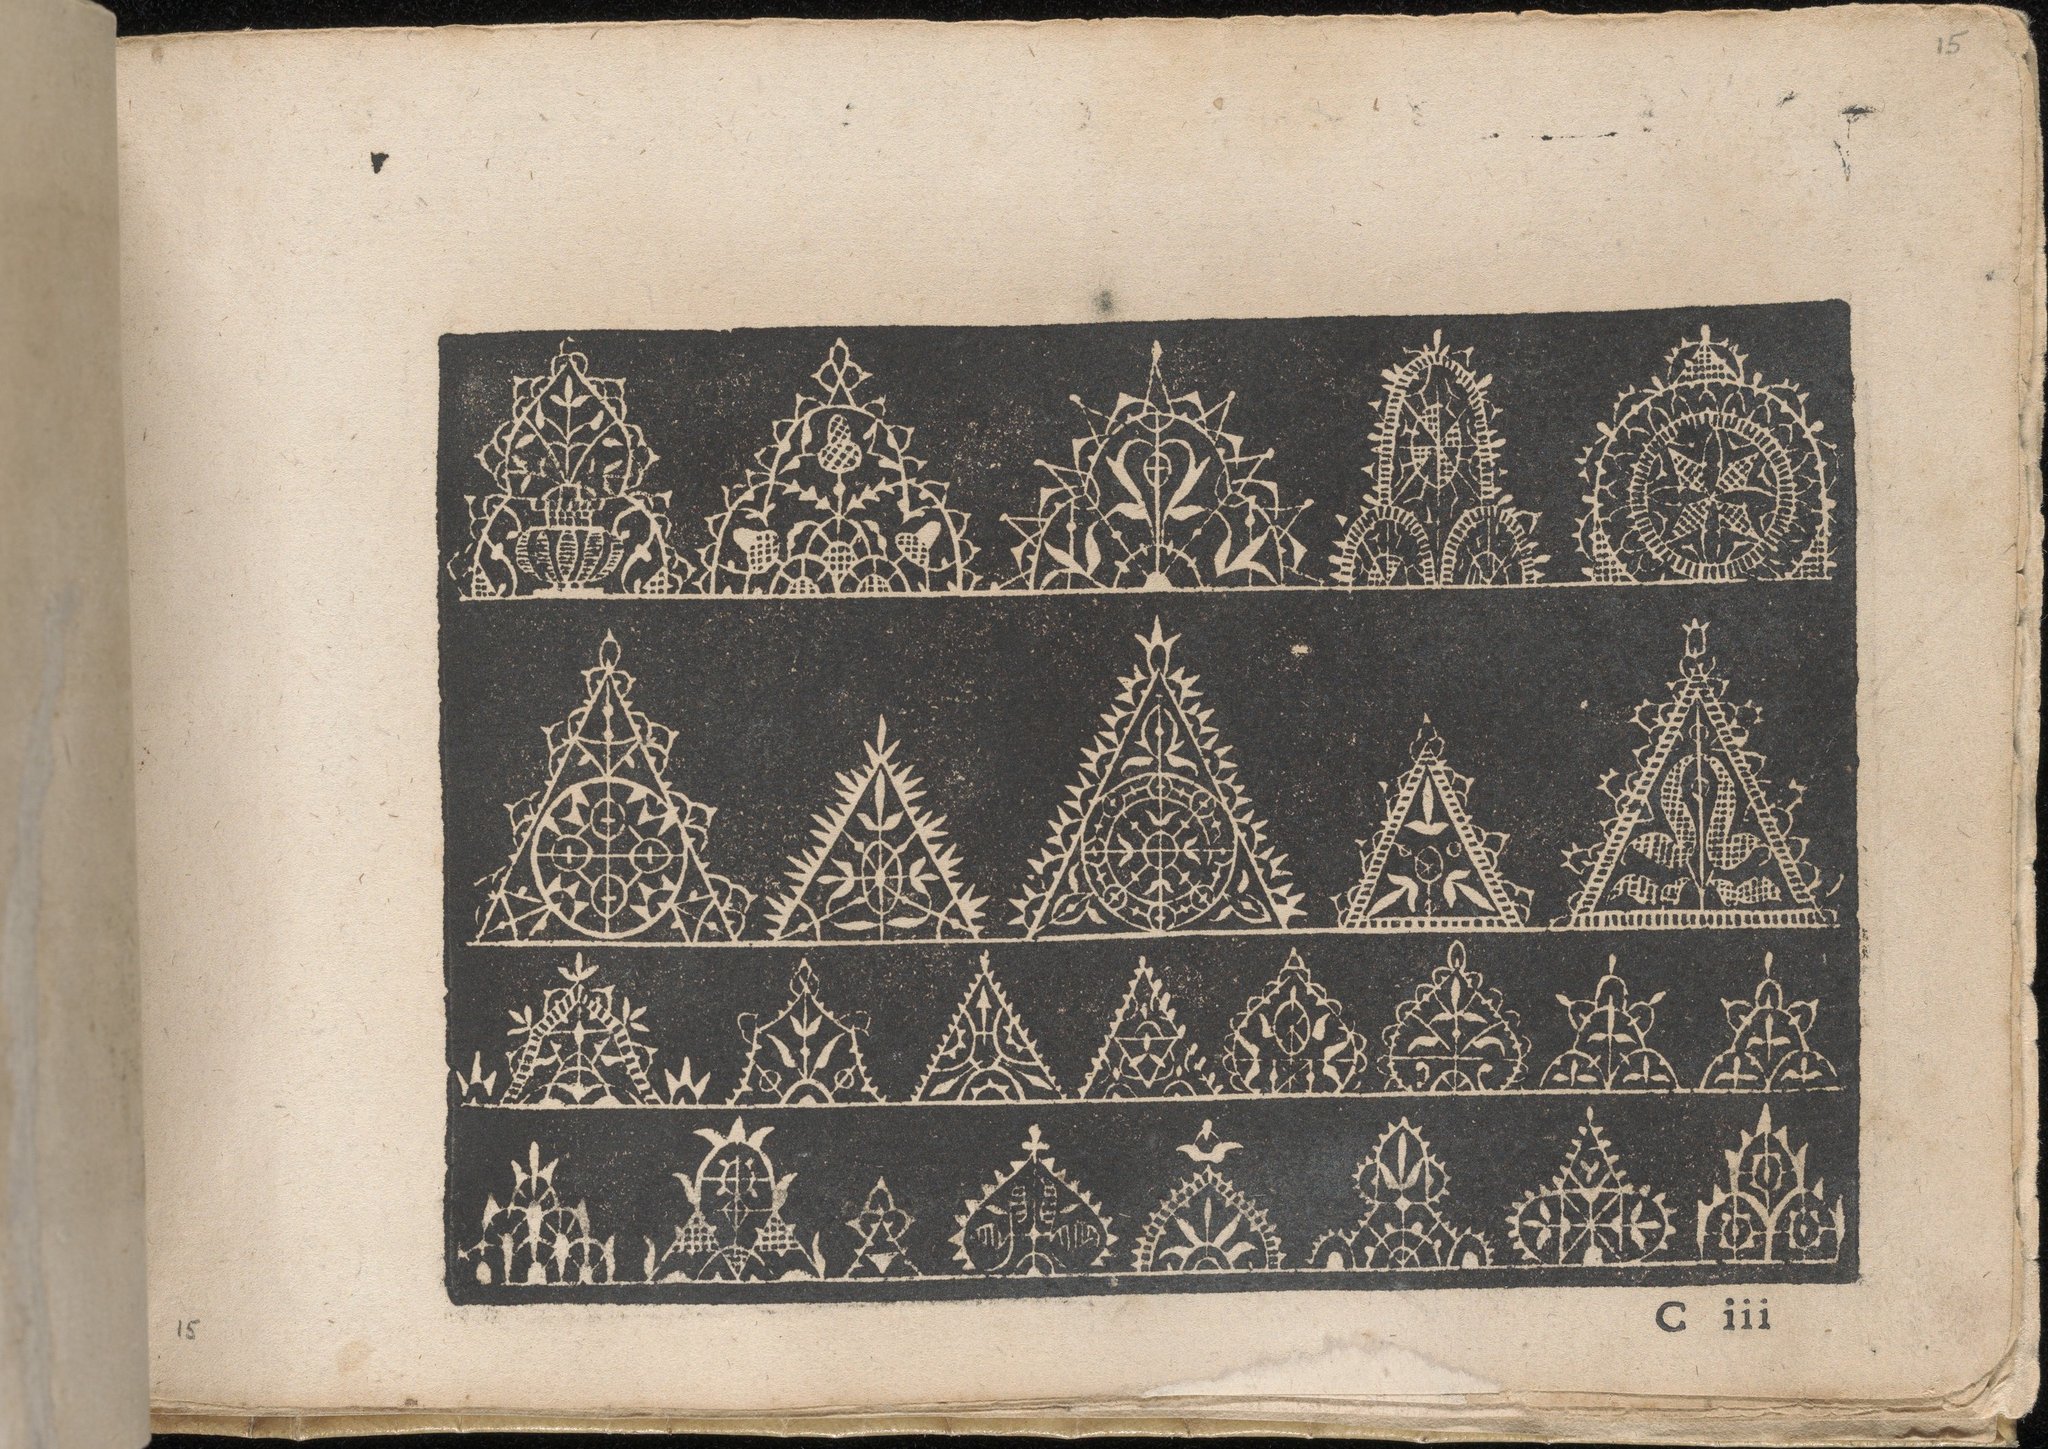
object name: book print ornament archiecture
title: Fiori di Ricami Nuovamente Posti in Luce, page 15 (recto)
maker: matteo florimi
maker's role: designer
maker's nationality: italian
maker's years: 1581-1613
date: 1591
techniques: woodcut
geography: italy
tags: ornament